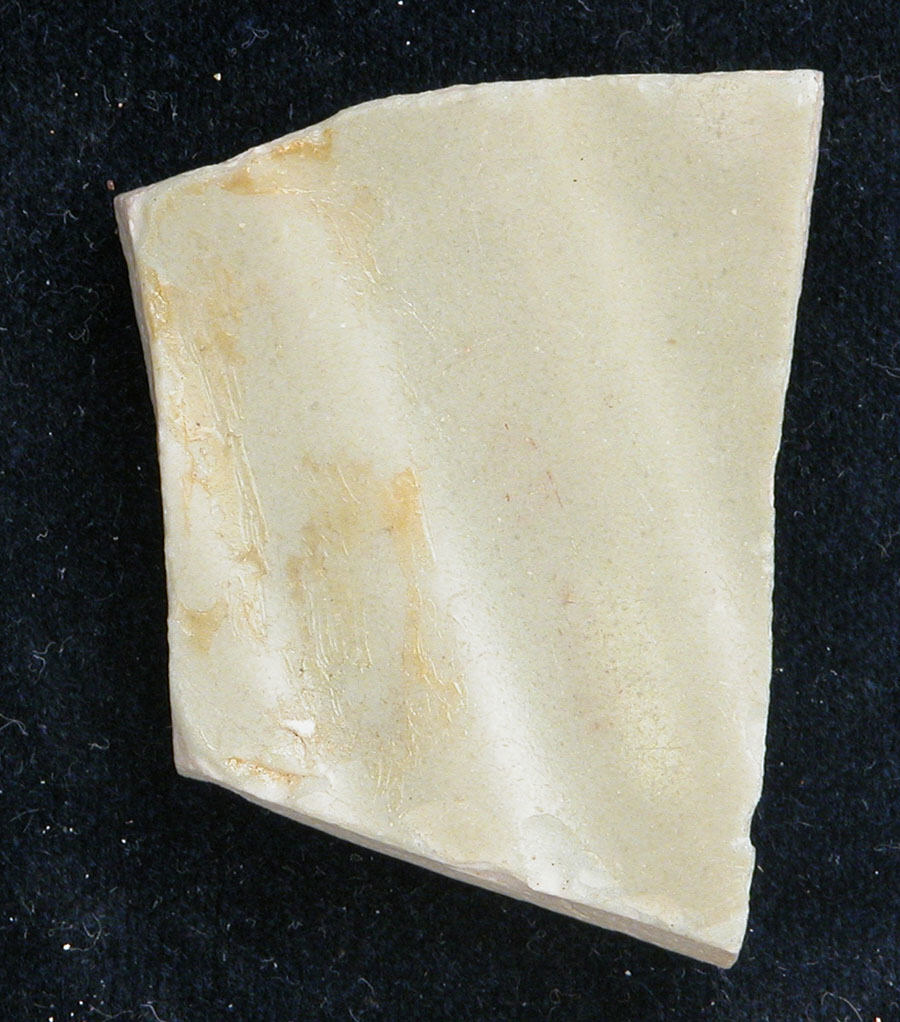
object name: fragment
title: Ceramic Fragment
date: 1001-1200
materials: ceramic glaze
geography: saudi arabia